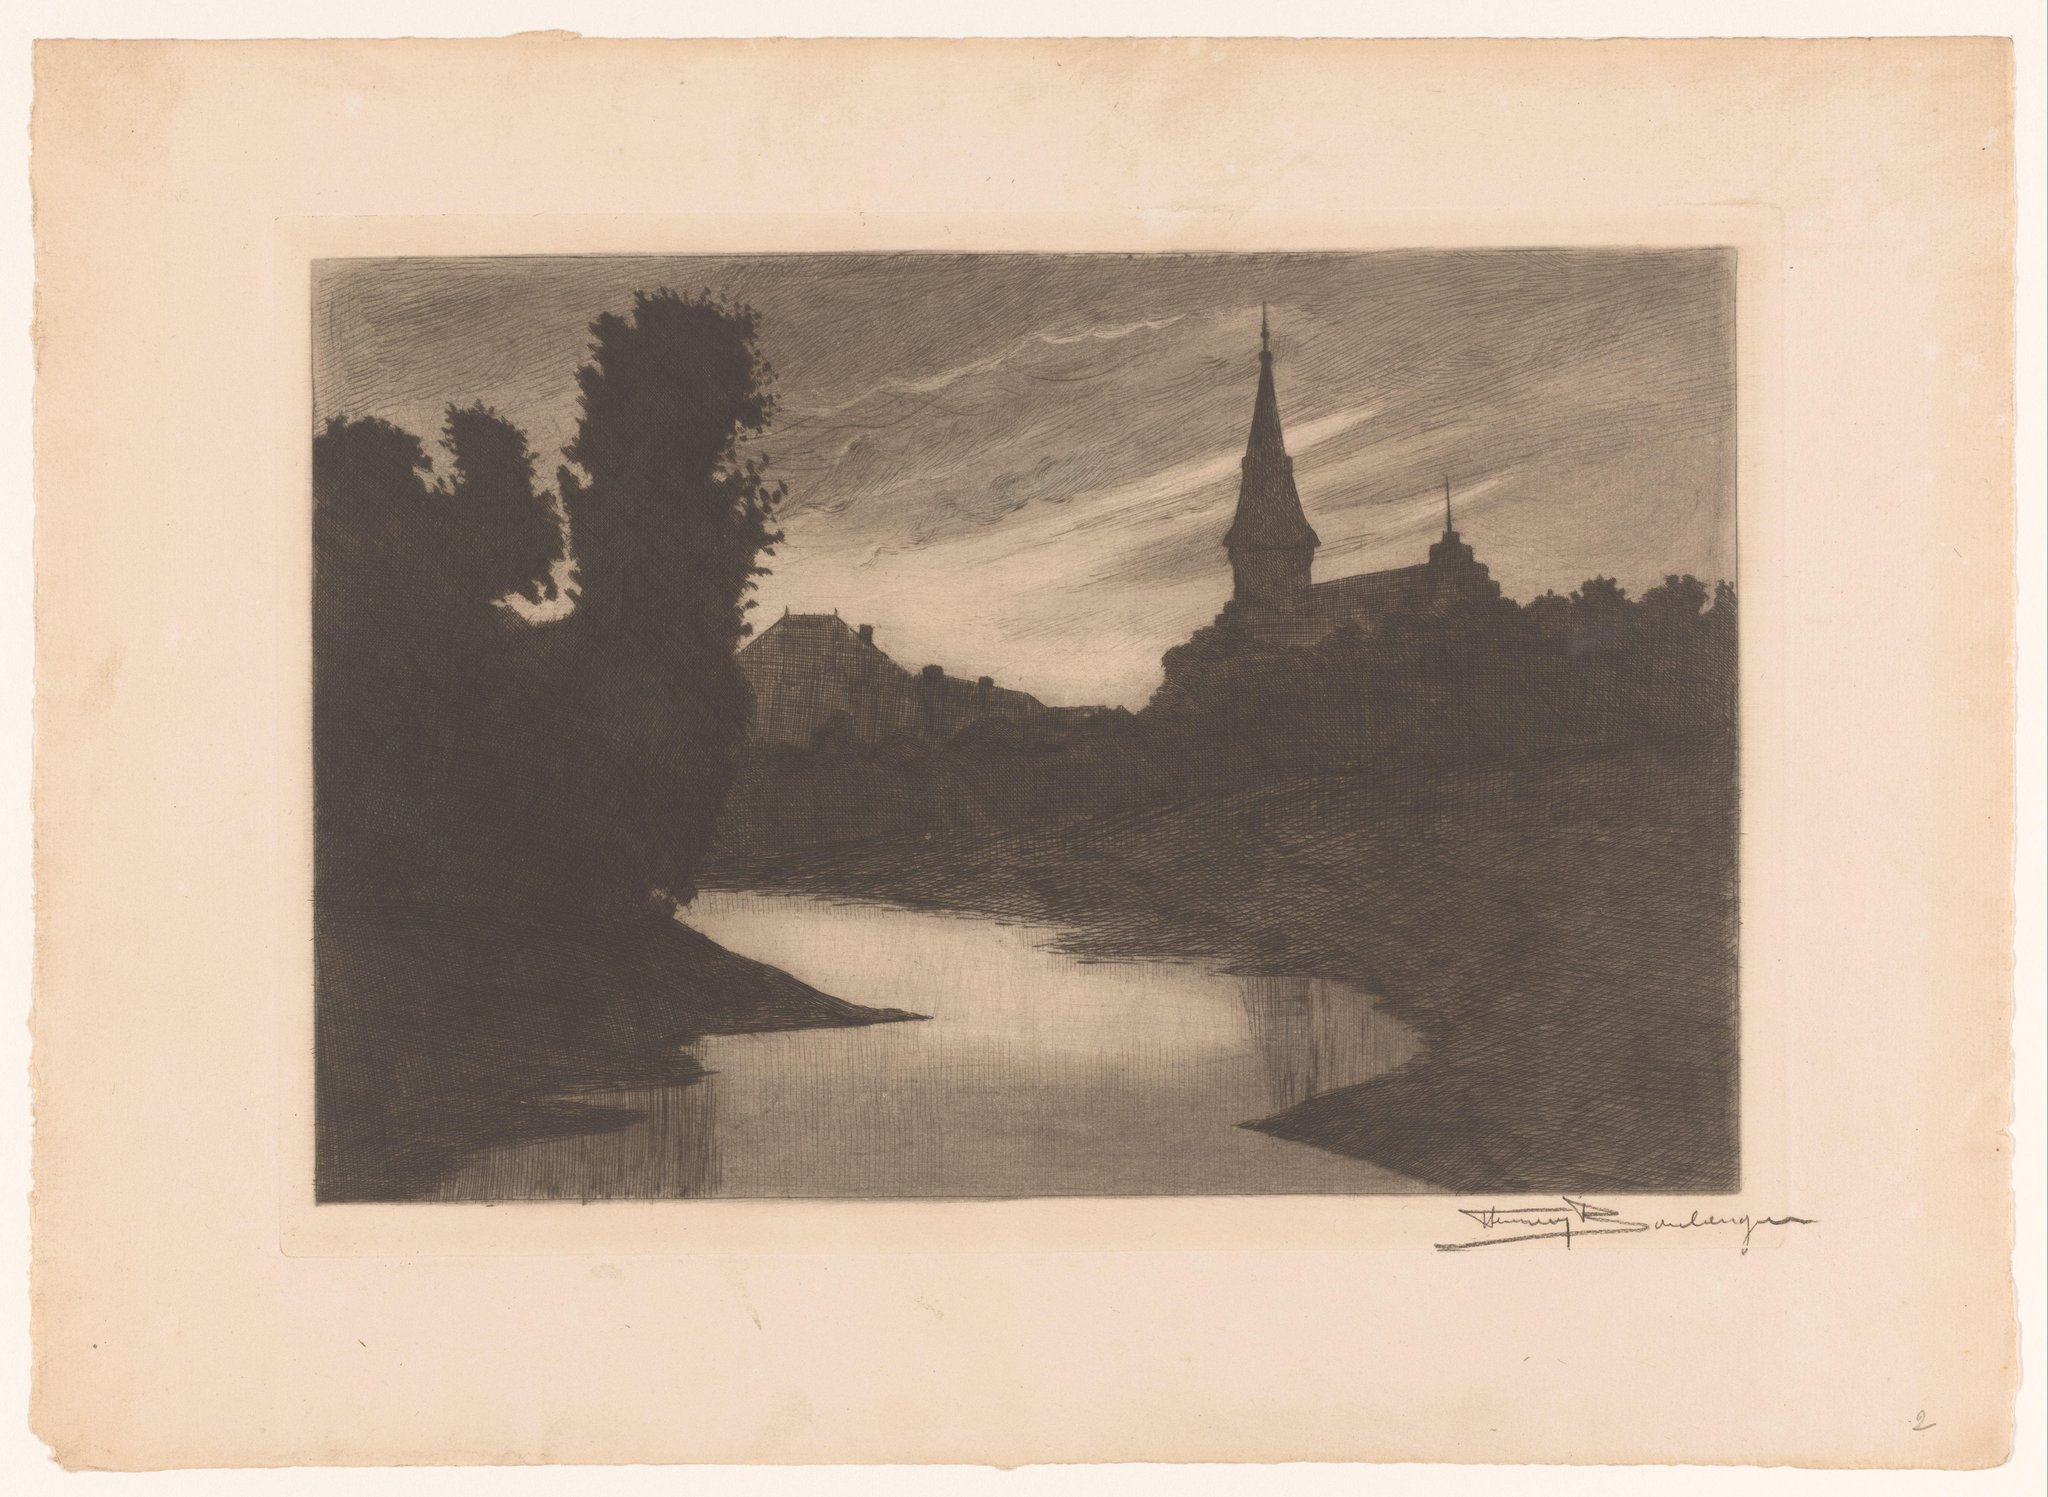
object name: print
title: Nachtgezicht van een dorp met kerk aan een water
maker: herman boulenger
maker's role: draughtsman, print maker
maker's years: 1871-1913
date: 1893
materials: paper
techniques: drypoint, etching, intaglio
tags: river, church (exterior)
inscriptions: collector's mark: Lugt 2228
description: Sterfdatum kunstenaar onbekend. Derhalve is voor bepaling van de rechten van dit object de vervaardigingsdatum aangehouden.